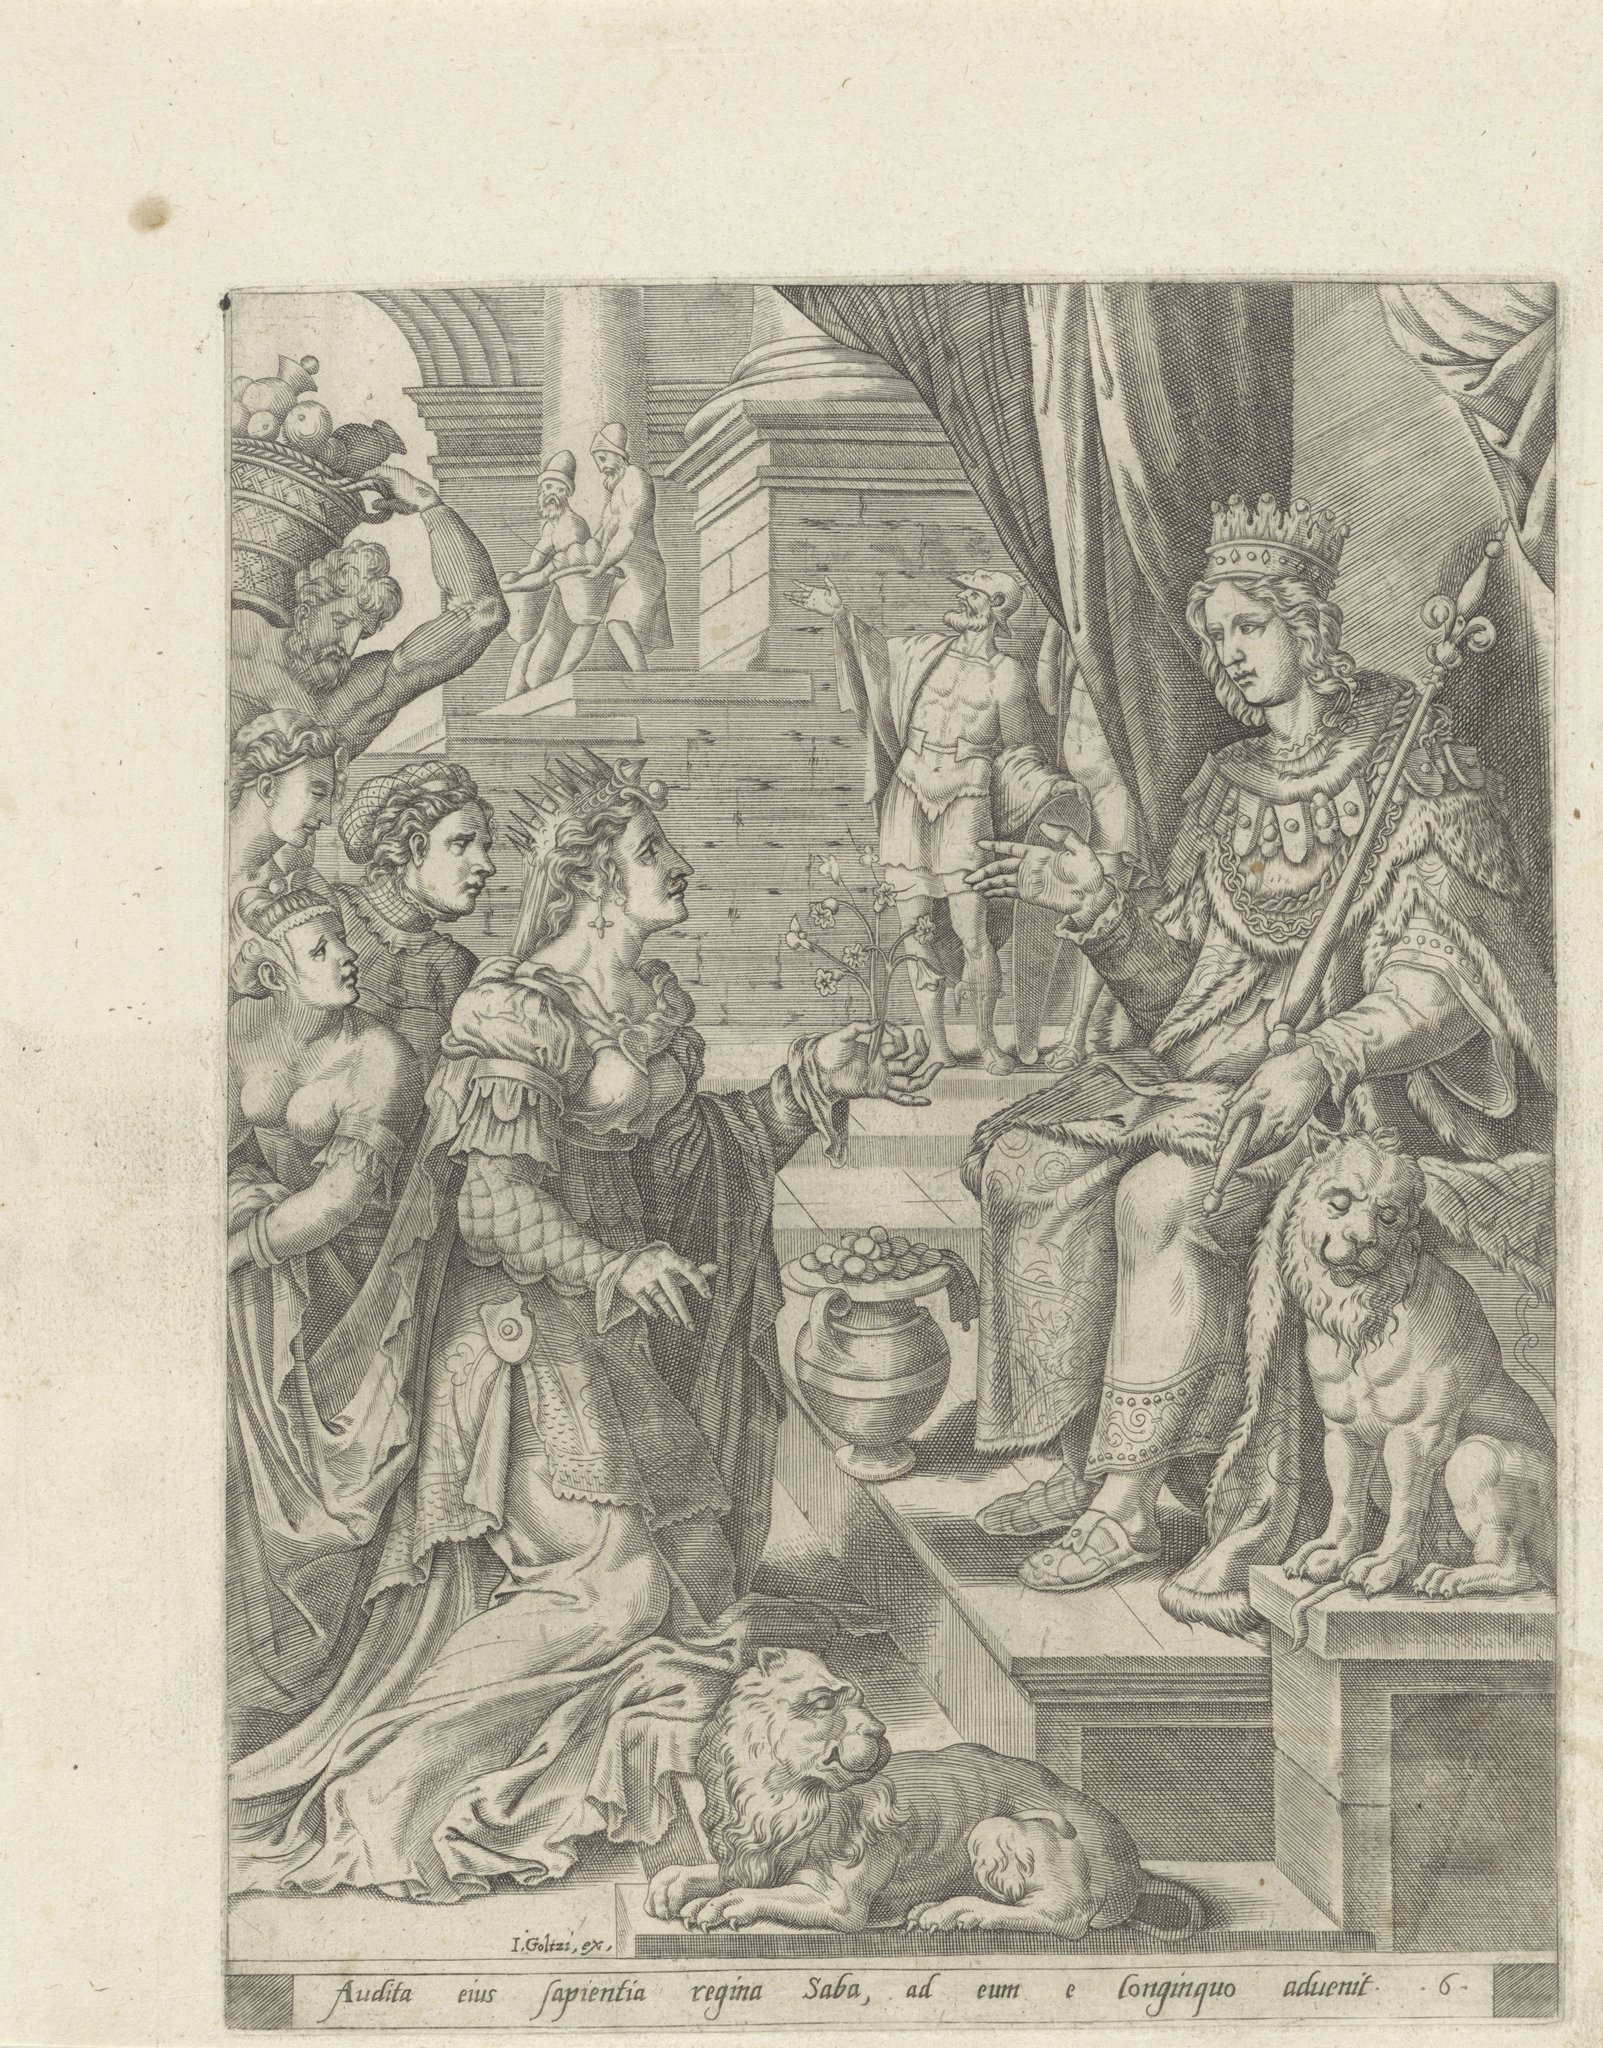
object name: print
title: Bezoek van de koningin van Seba aan Salomo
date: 1560-1595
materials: paper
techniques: engraving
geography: antwerp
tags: homage to solomon: the queen of sheba gives solomon gold, precious stones and spices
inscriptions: collector's mark: Lugt 2760, collector's mark: Lugt 2228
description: Salomo zit op zijn troon. Voor hem knielt de koningin van Seba met bloemen in haar hand. Bij haar staat een kruik met munten. Achter haar enkele dienaren met nog meer geschenken. Onderaan in de marge een éénregelig onderschrift in het Latijn.